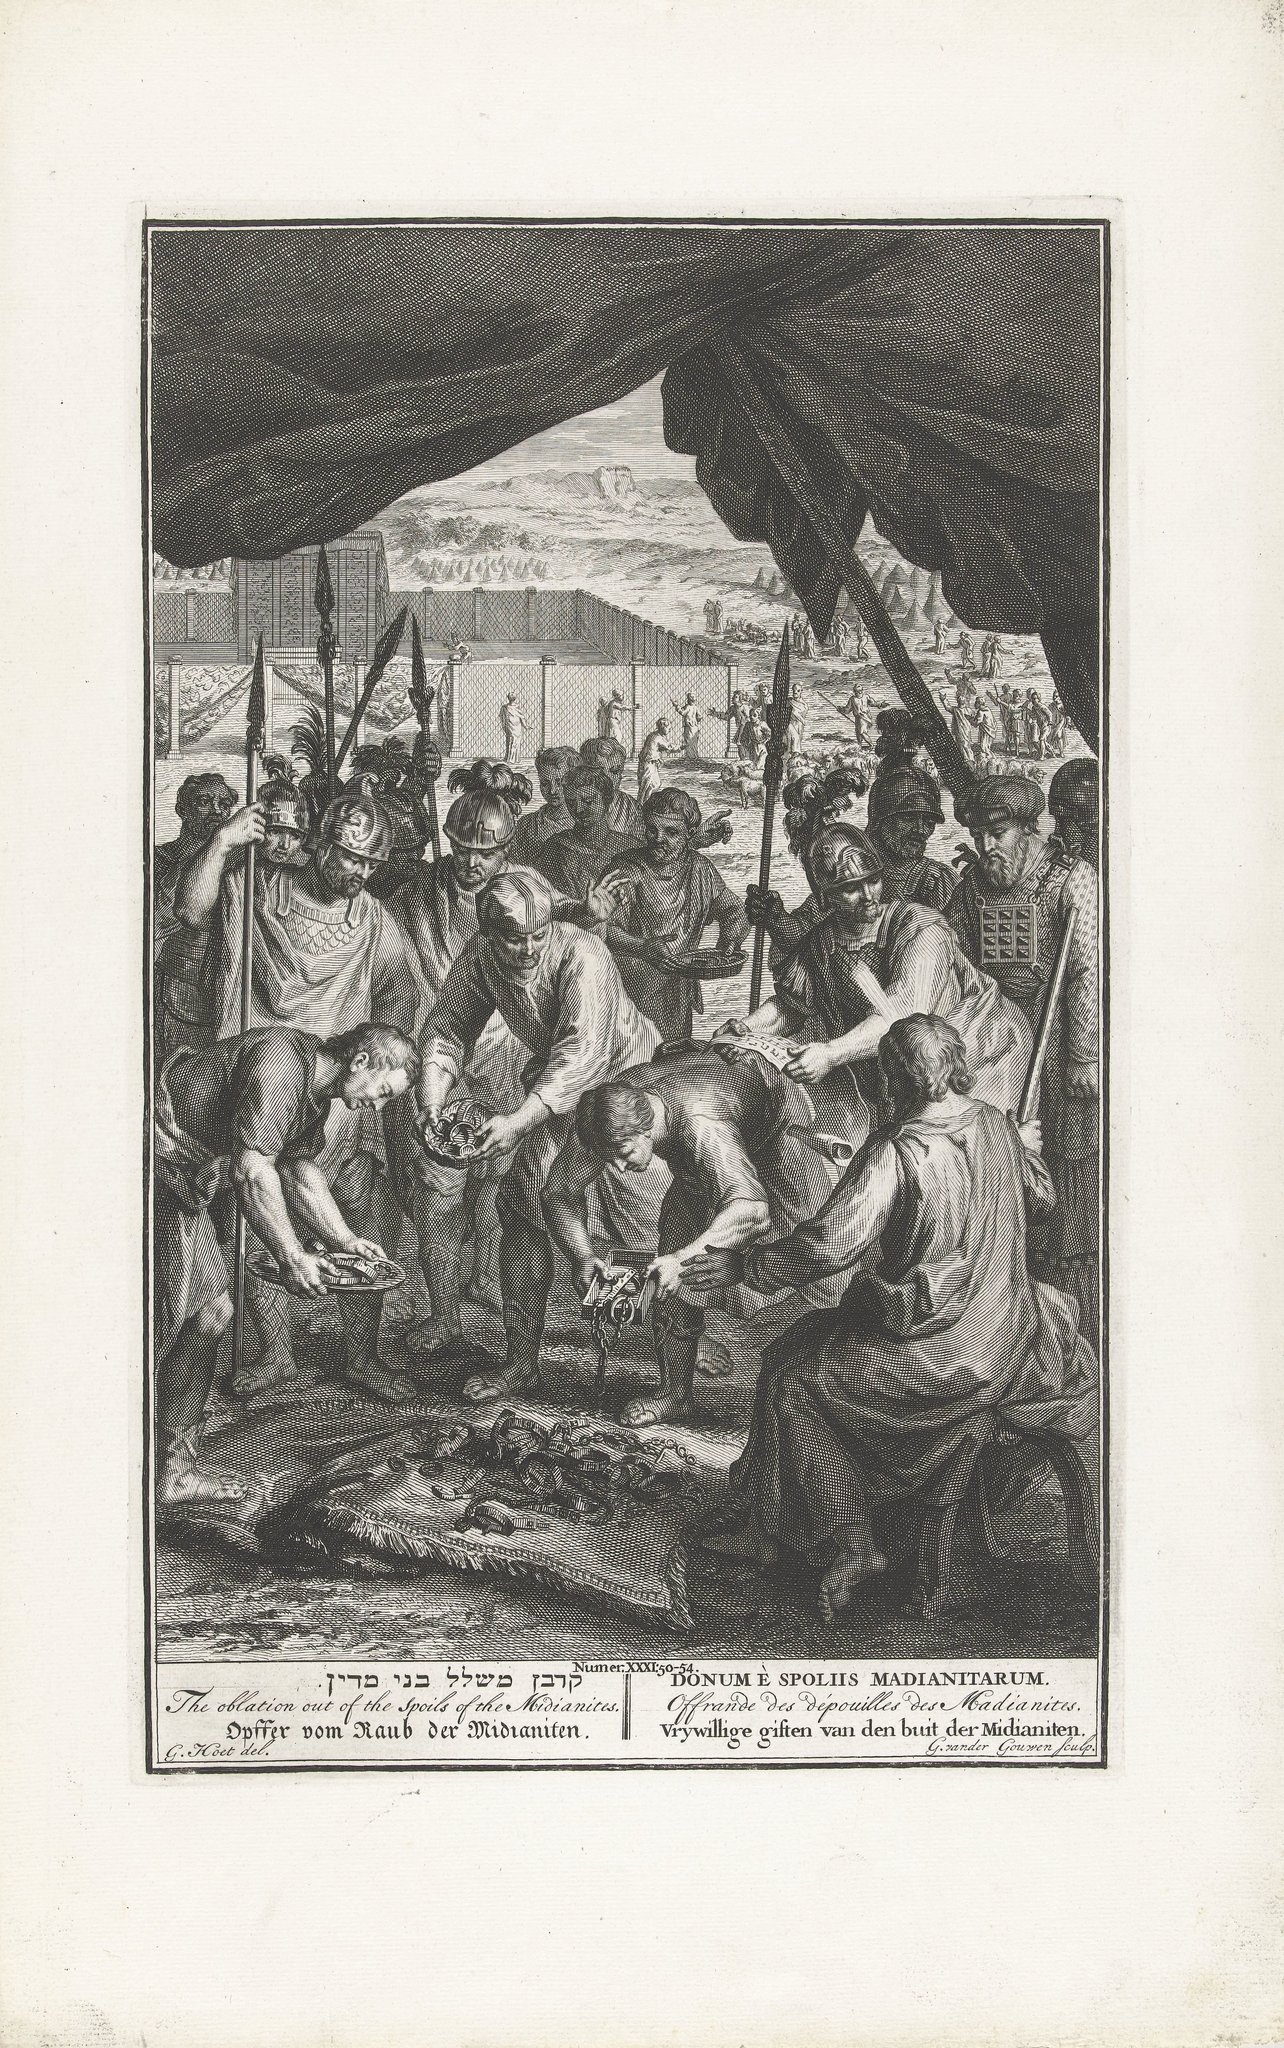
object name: print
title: Offerande van de buit van de Midjanieten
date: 1728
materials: paper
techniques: engraving, etching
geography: amsterdam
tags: the officer's oblation after the battle of the israelites against the midianites; moses and eleazar take the gifts to the tabernacle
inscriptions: inscription: ‘utrechts Fundatie huijs’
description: Mozes en de priester Eleazar nemen de gouden sieraden uit de buit van de Midjanieten aan als offerande voor God (Num. 31:50-54). De prent heeft een Hebreeuws, Latijns, Frans, Engels, Duits en Nederlands onderschrift.